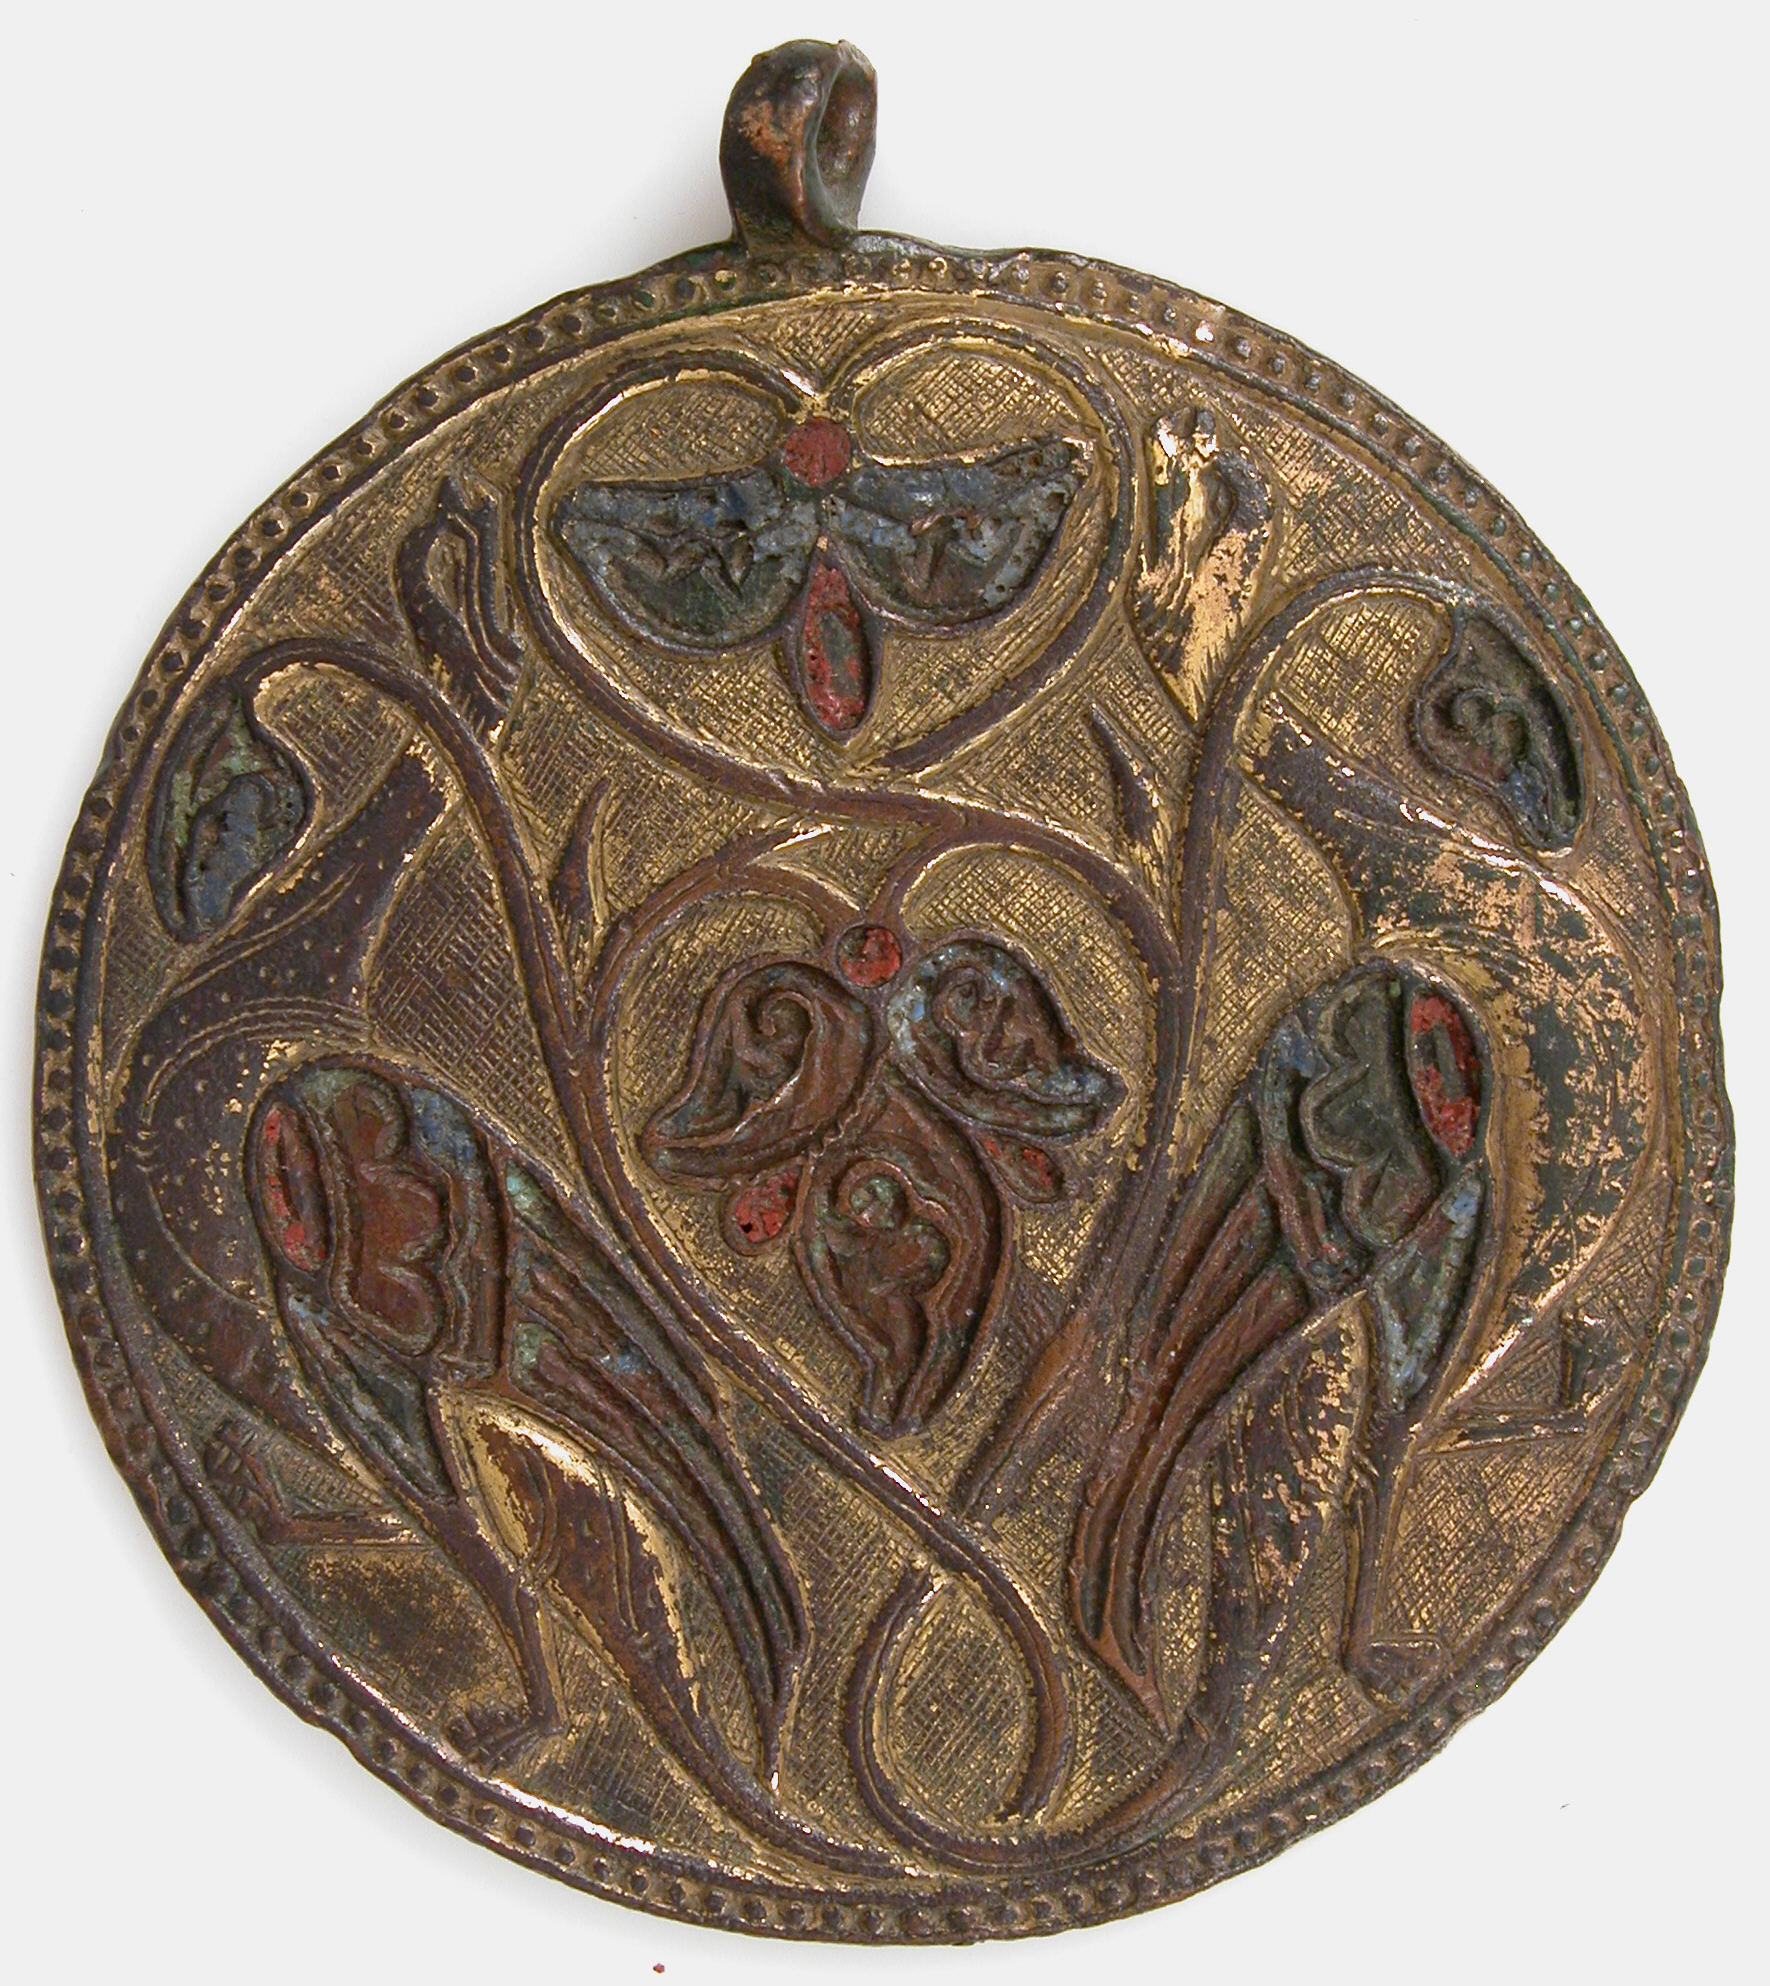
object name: medallion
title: Pendant Medallion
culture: french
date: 1180-1190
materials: copper, enamel, gilt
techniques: enamel, engraving, stamping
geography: france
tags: birds,medallions